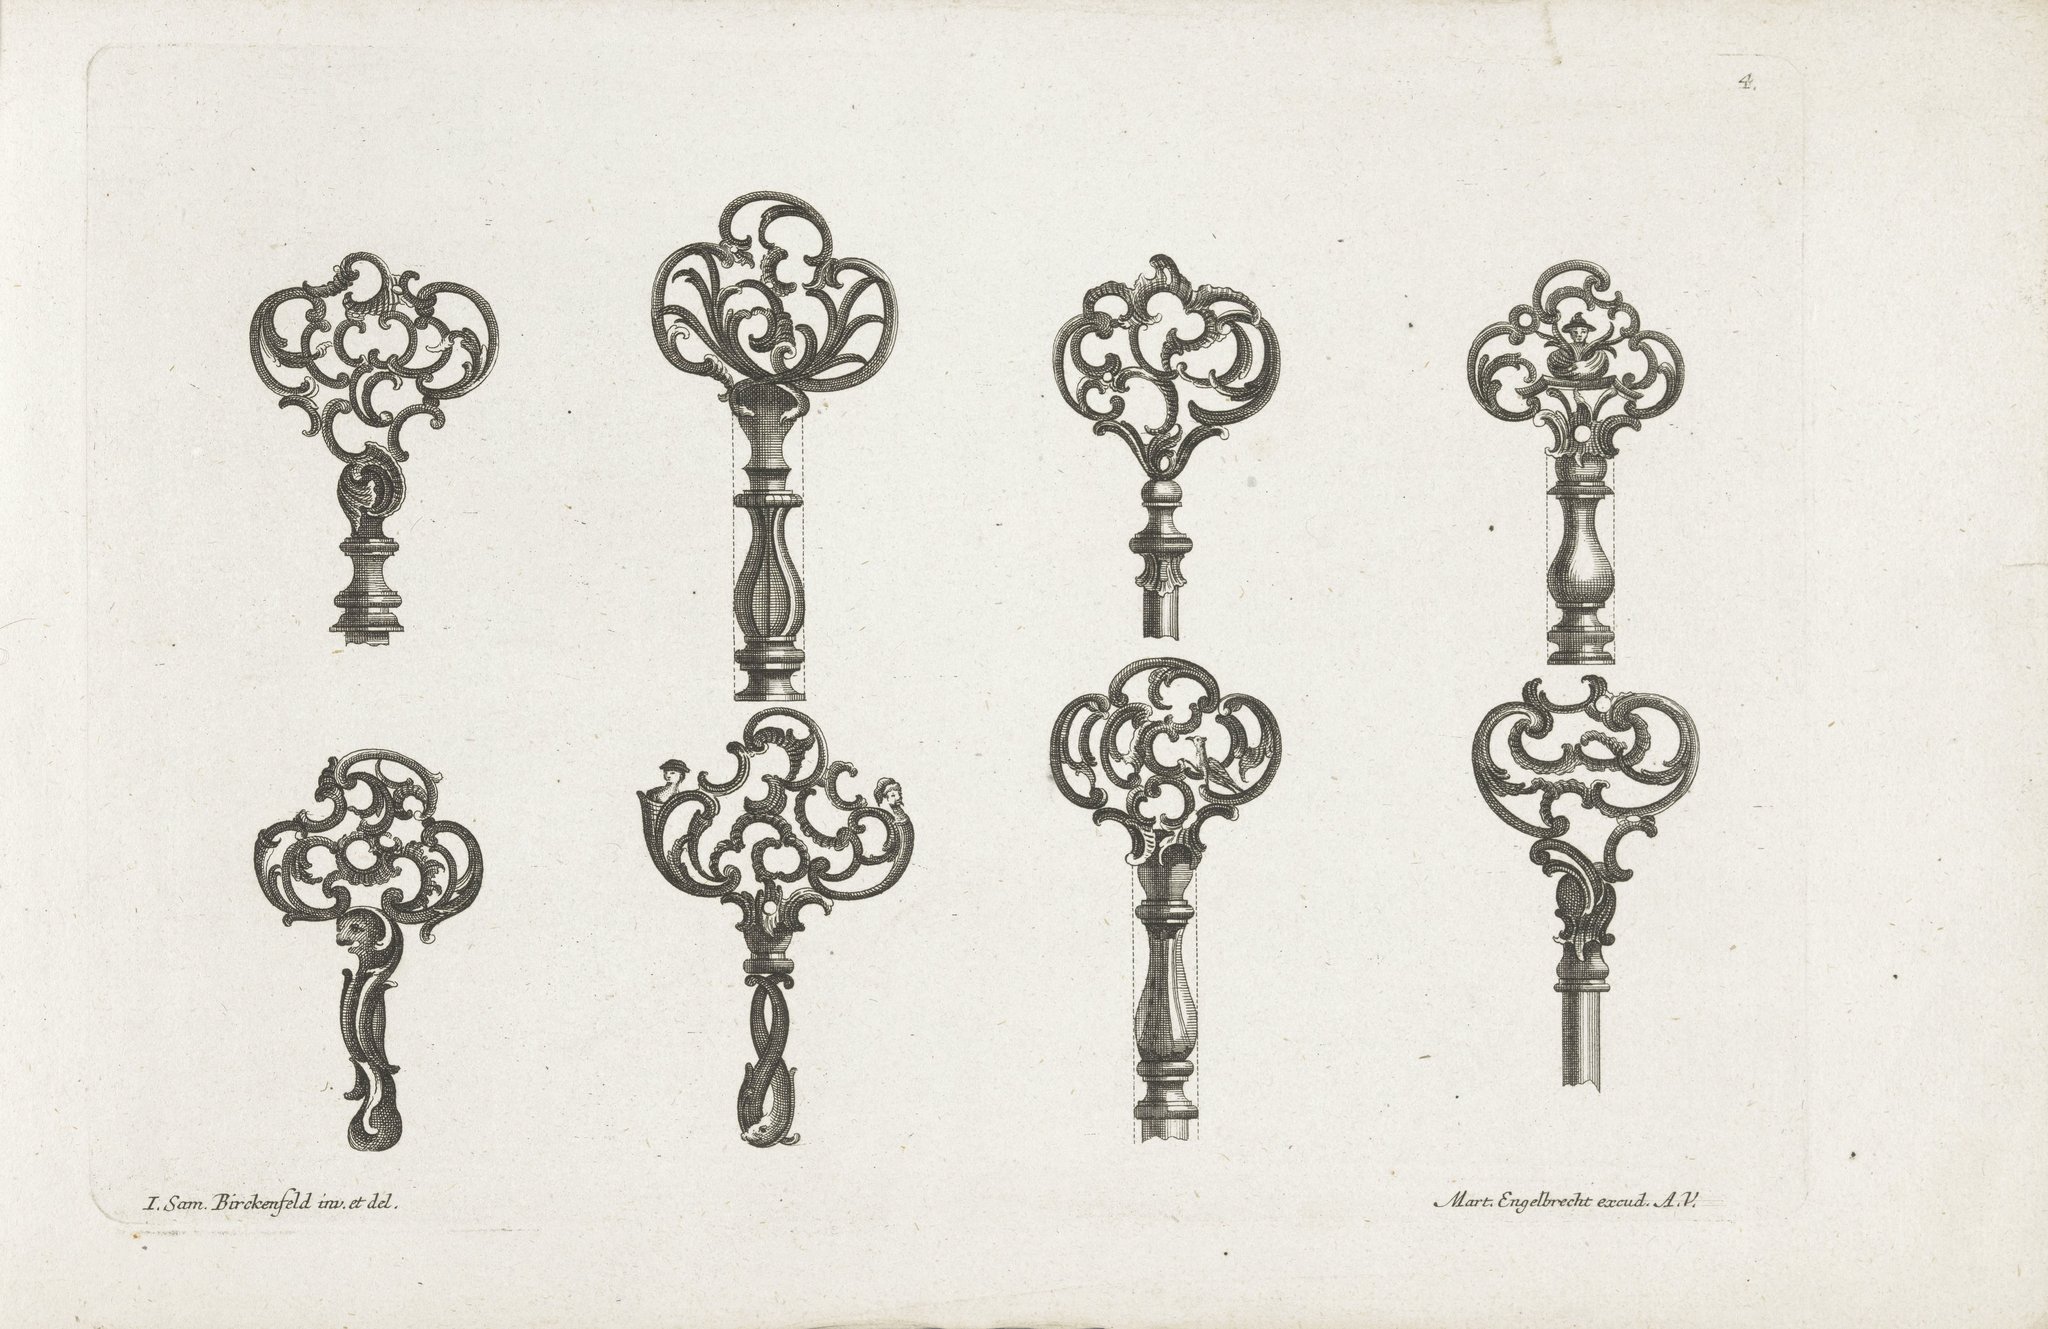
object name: print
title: Ontwerpen voor sloten en sleutels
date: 1694-1756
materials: paper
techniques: etching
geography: augsburg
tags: animals, key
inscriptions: collector's mark: Lugt 2228